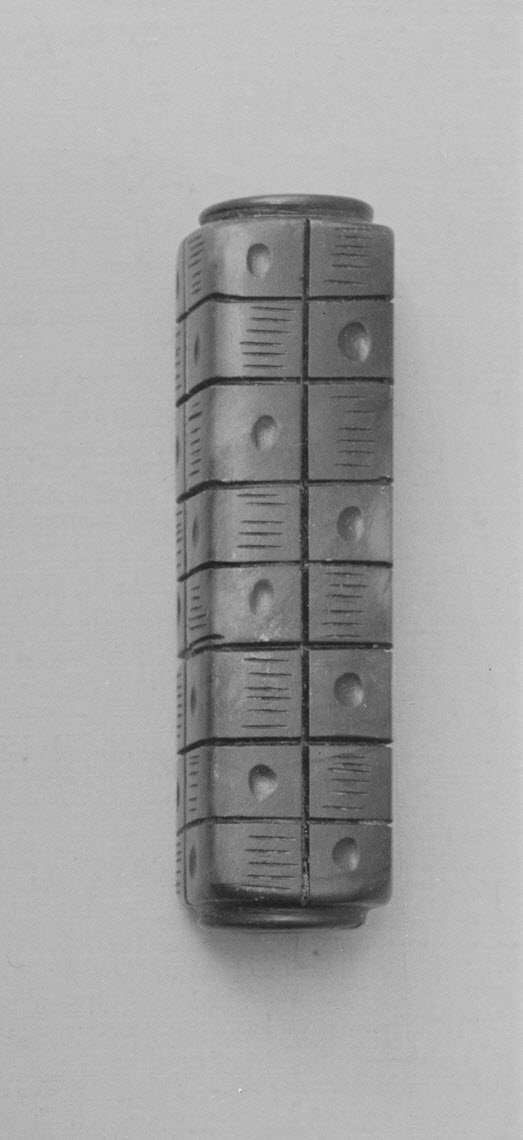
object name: bead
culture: chinese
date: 206 BCE-220 CE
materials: jade